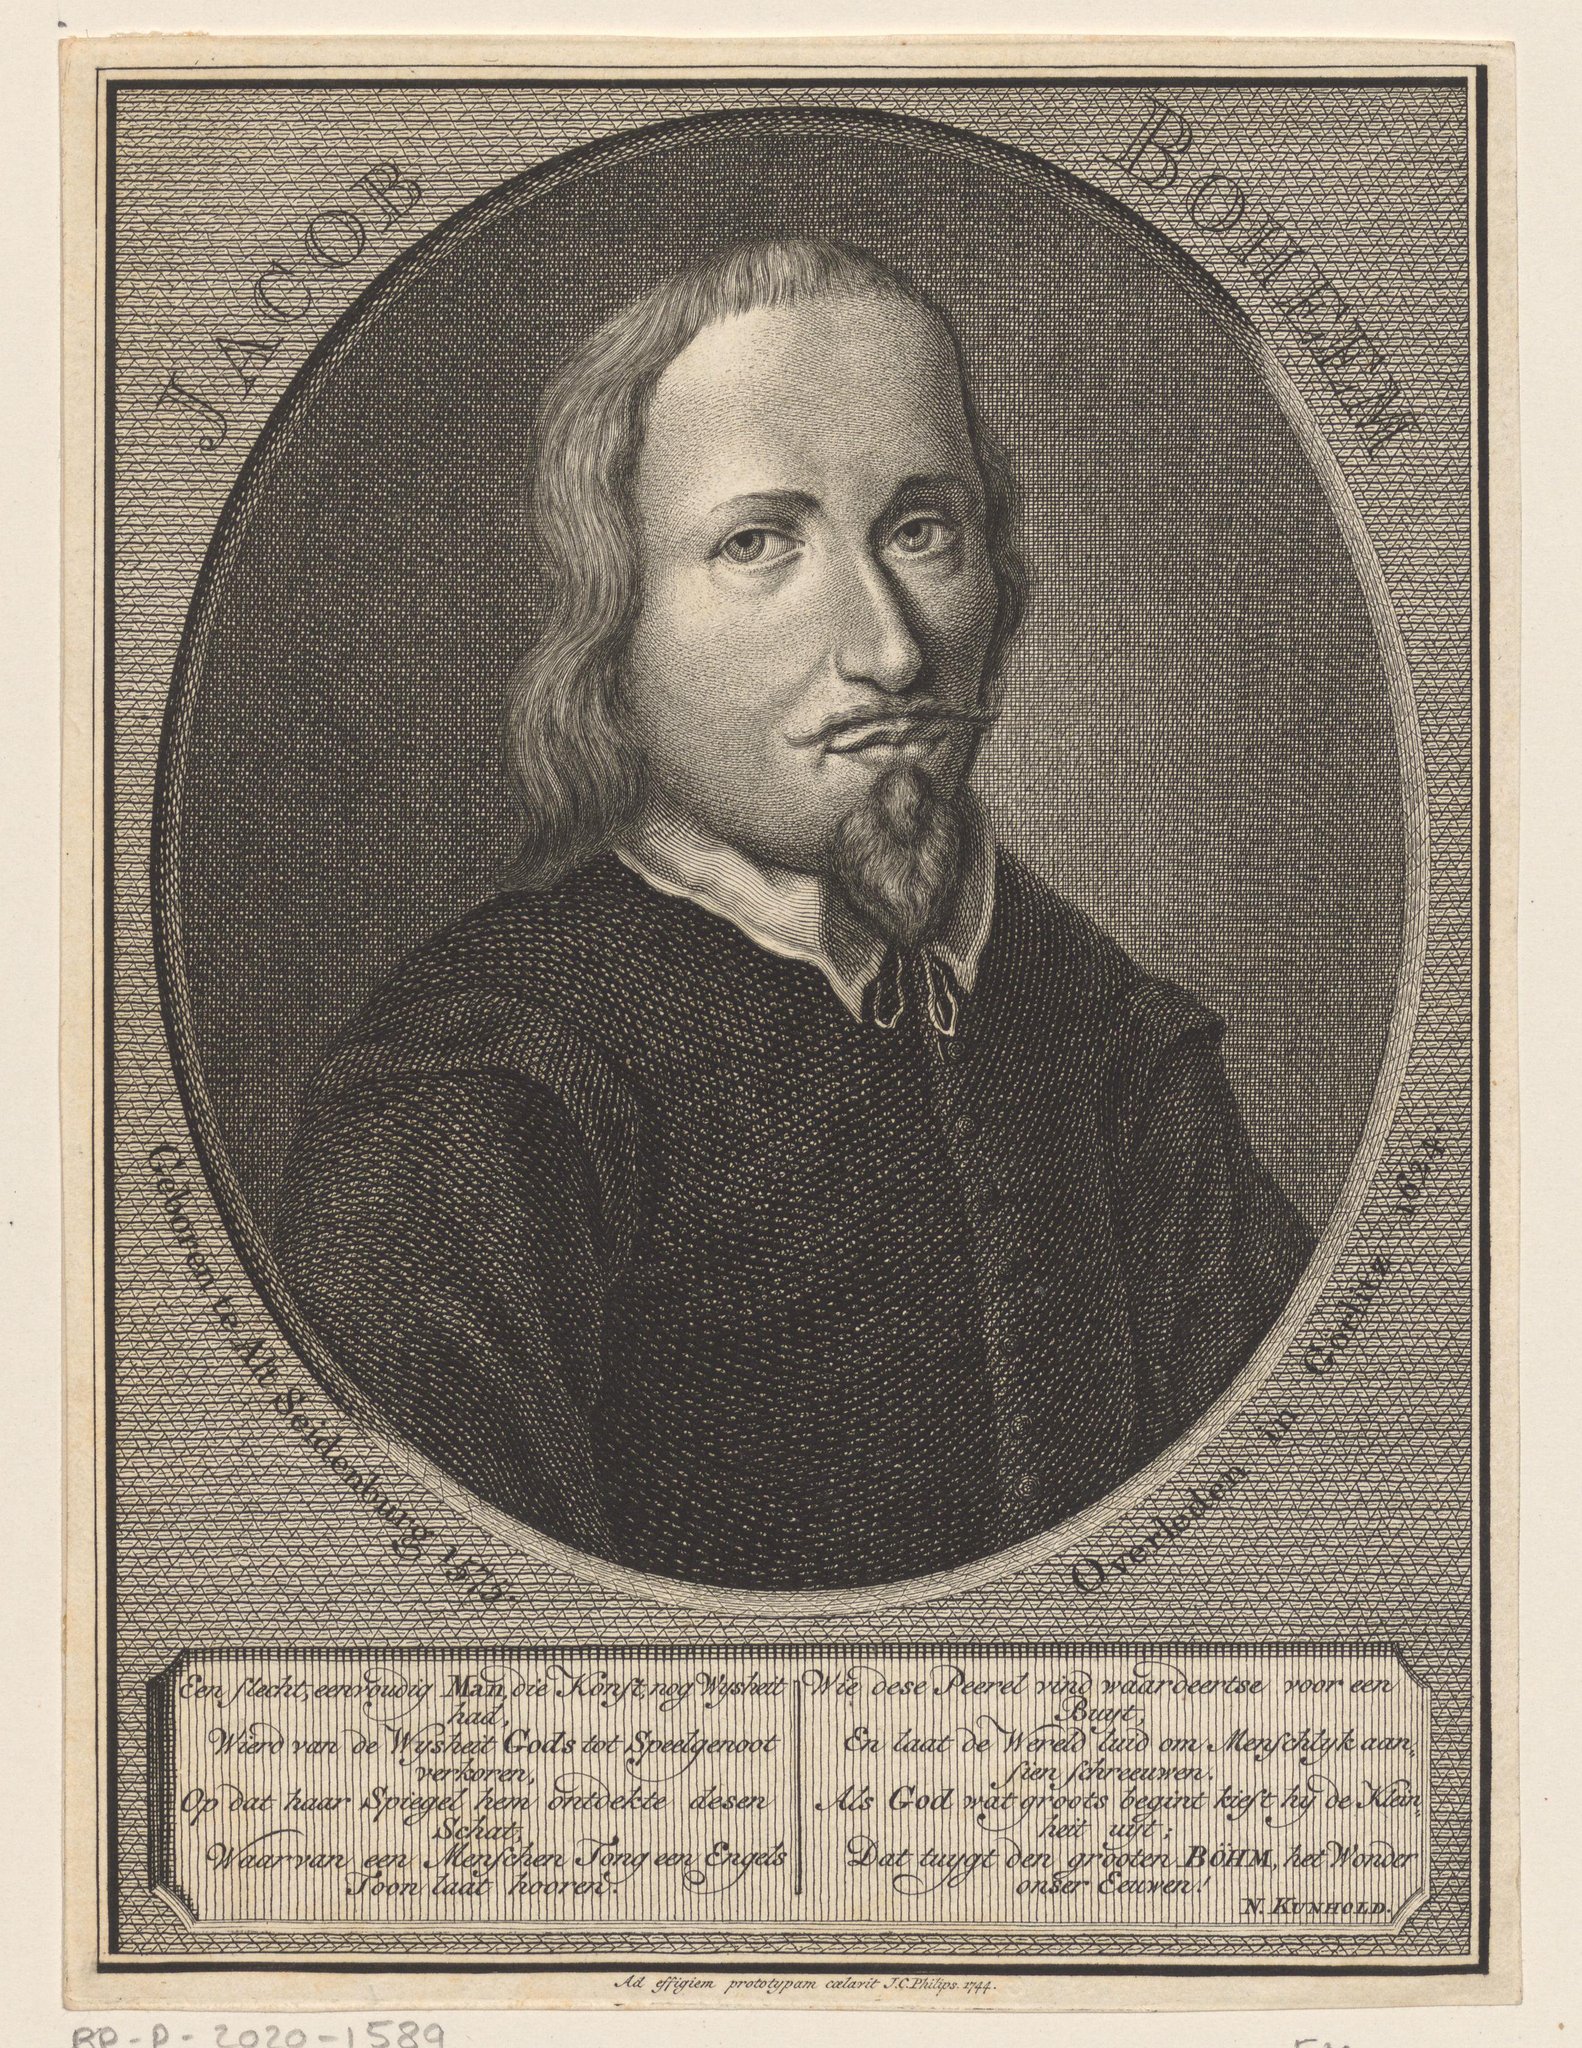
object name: print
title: Portret van Jakob Böhme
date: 1744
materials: paper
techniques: engraving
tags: theologian, historical persons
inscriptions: date